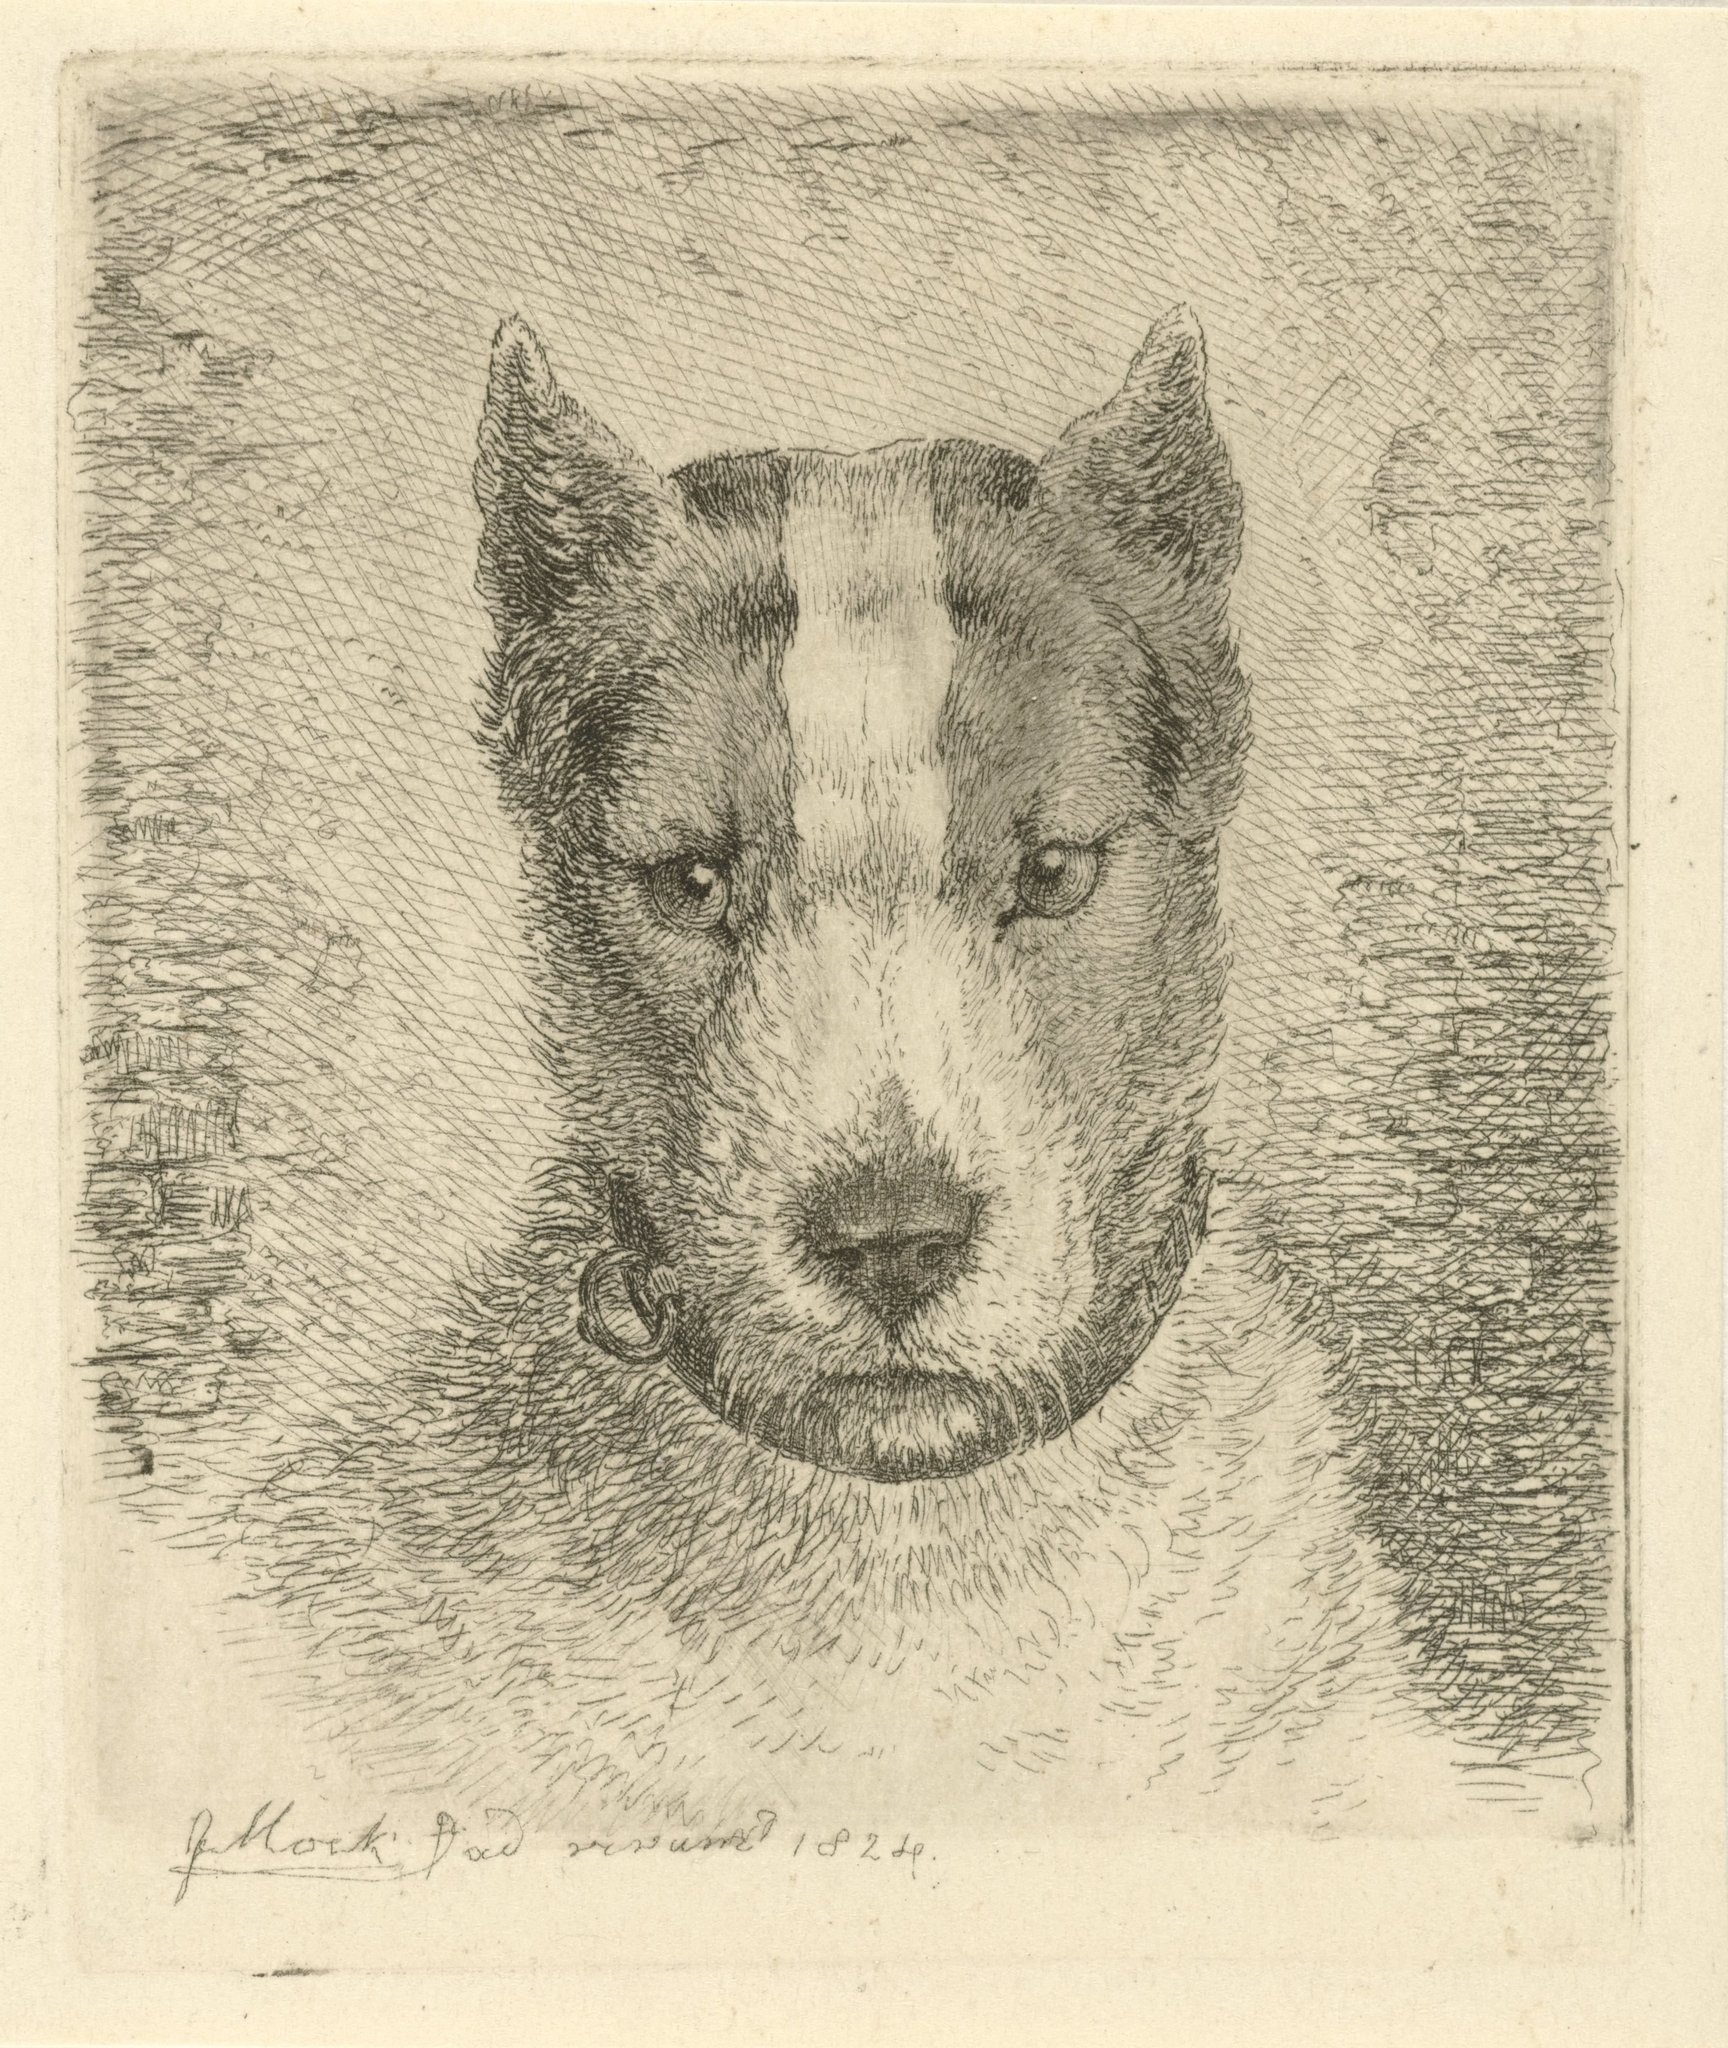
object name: print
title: Hondenkop met halsband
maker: johannes mock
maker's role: draughtsman, painter, print maker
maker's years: 1800-1884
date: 1824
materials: paper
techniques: etching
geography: netherlands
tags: dog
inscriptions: collector's mark: Lugt 2228